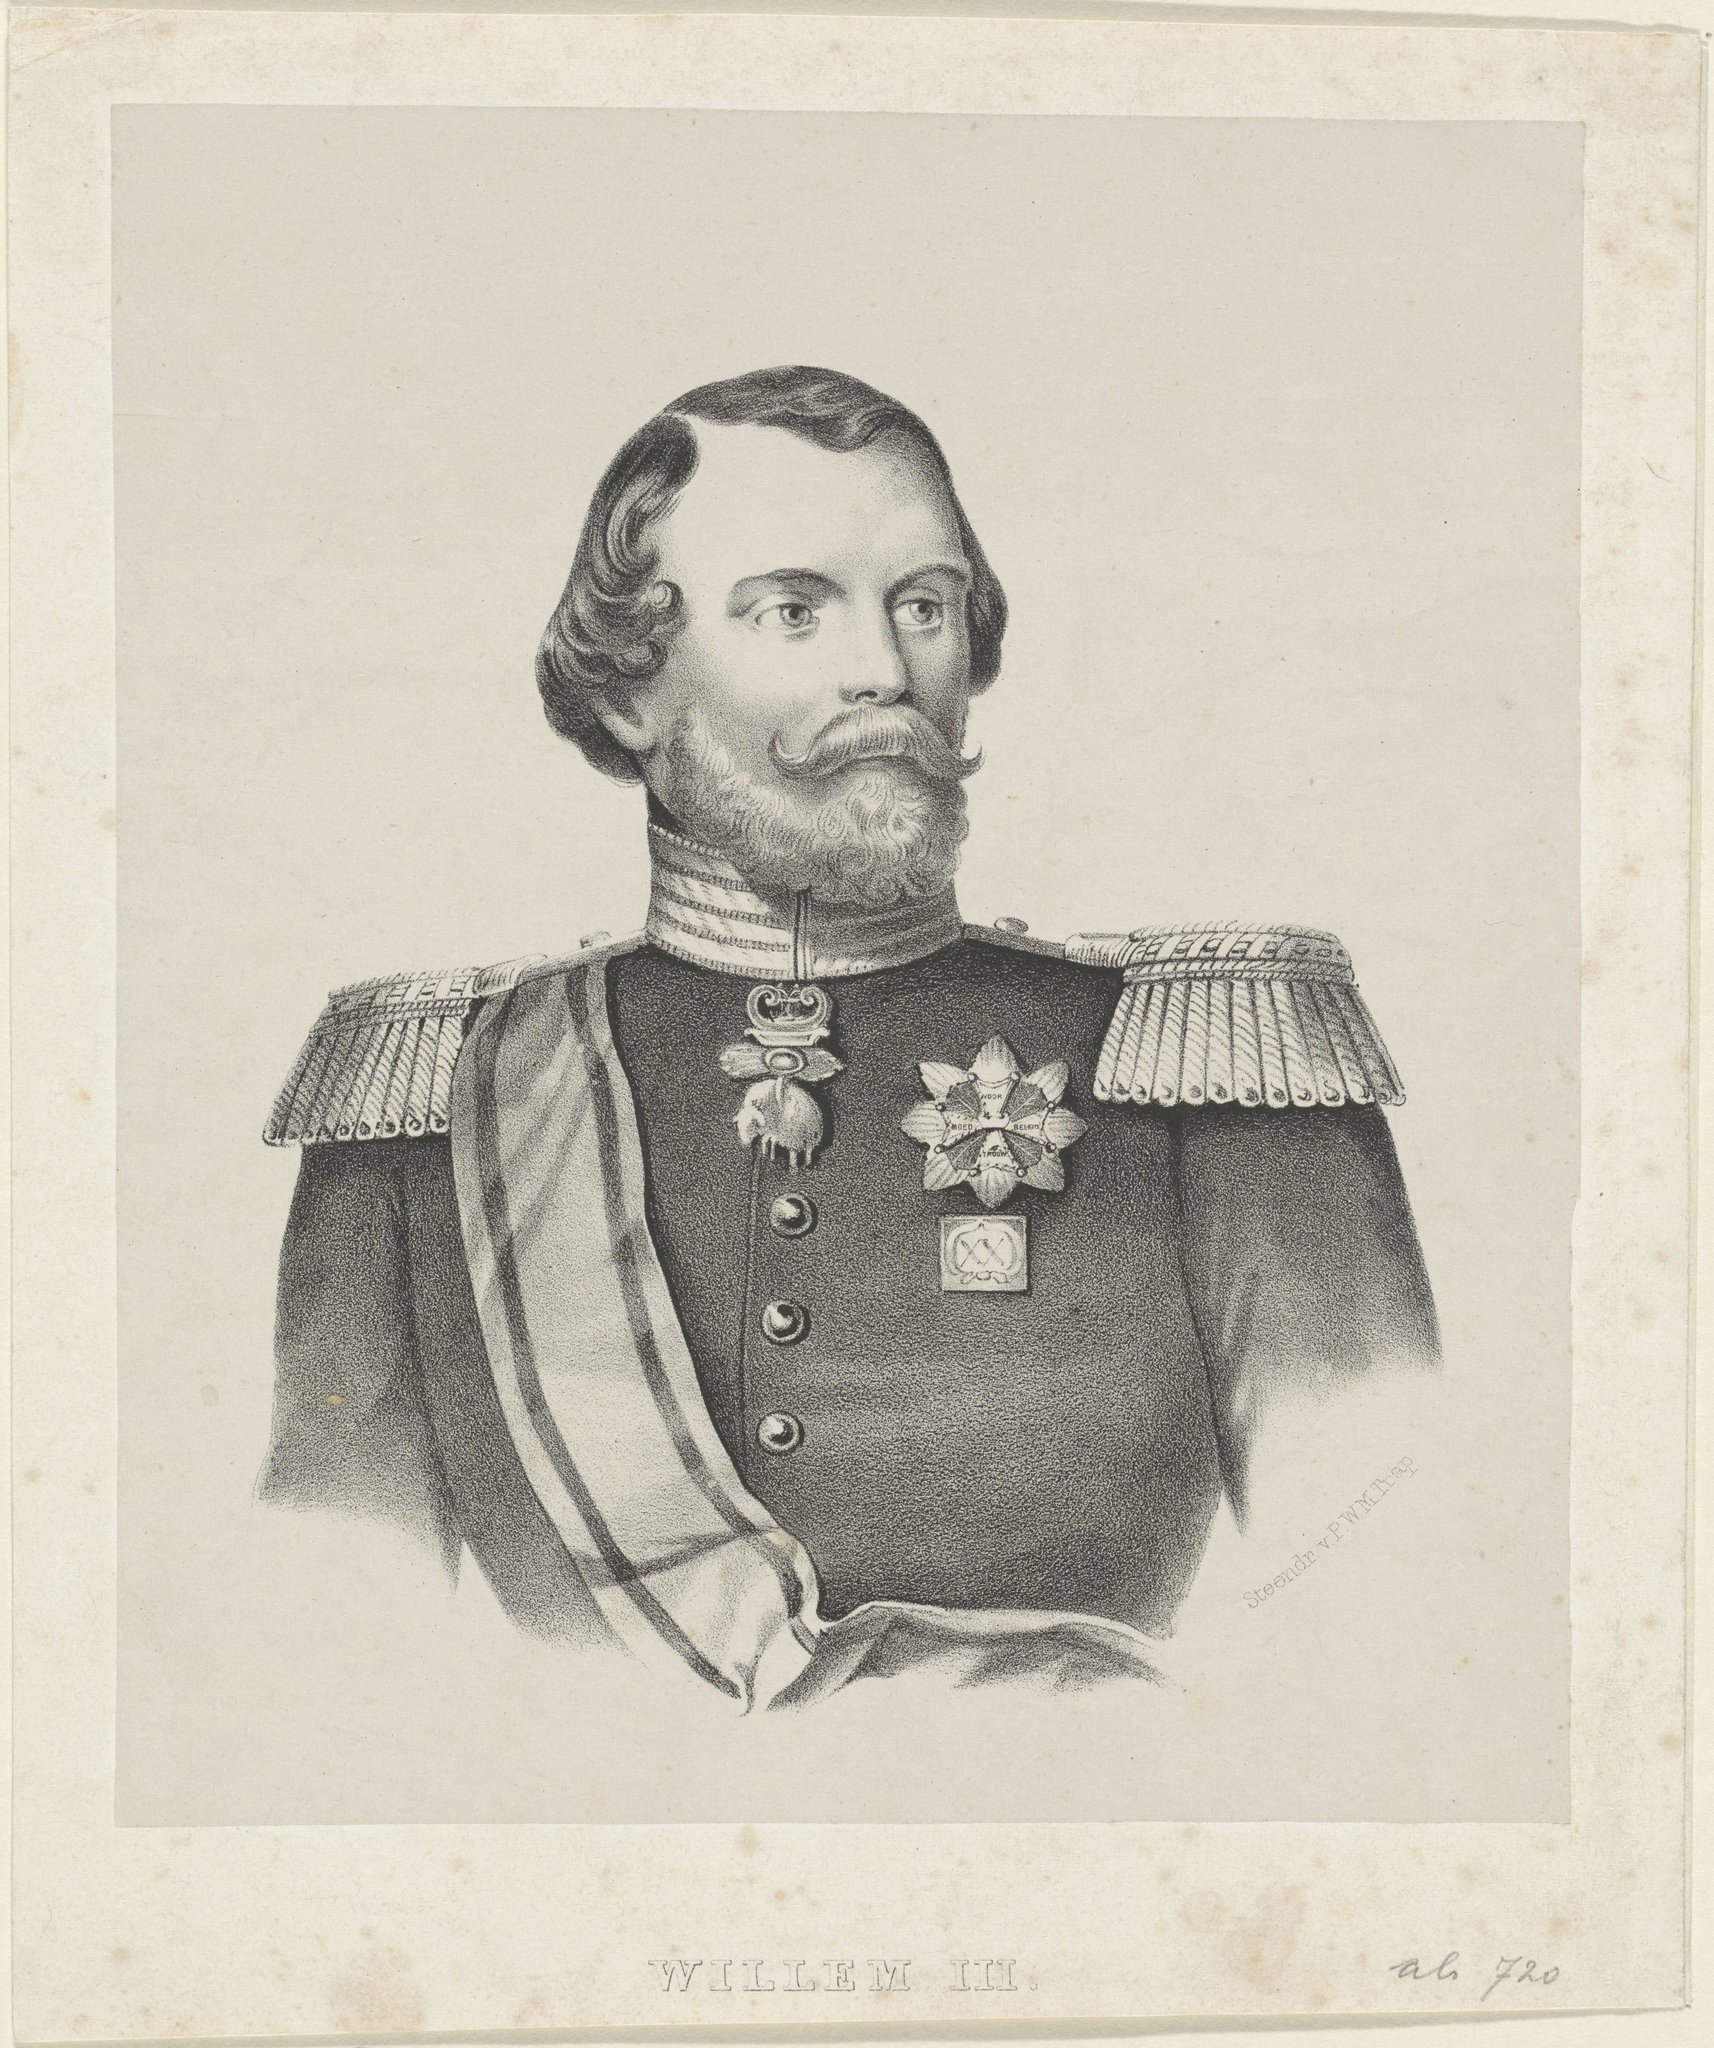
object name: print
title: Portret van Willem III, koning der Nederlanden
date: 1842-1905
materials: paper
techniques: lithograph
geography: leiden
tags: willem iii (koning der nederlanden), knighthood order (garter) - insignia of a knighthood order, e.g.: badge, chain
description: De hier vermelde titel verwijst naar de hoogst verkregen titel van de geportretteerde, niet per se naar de titel die de geportretteerde op deze voorstelling draagt.